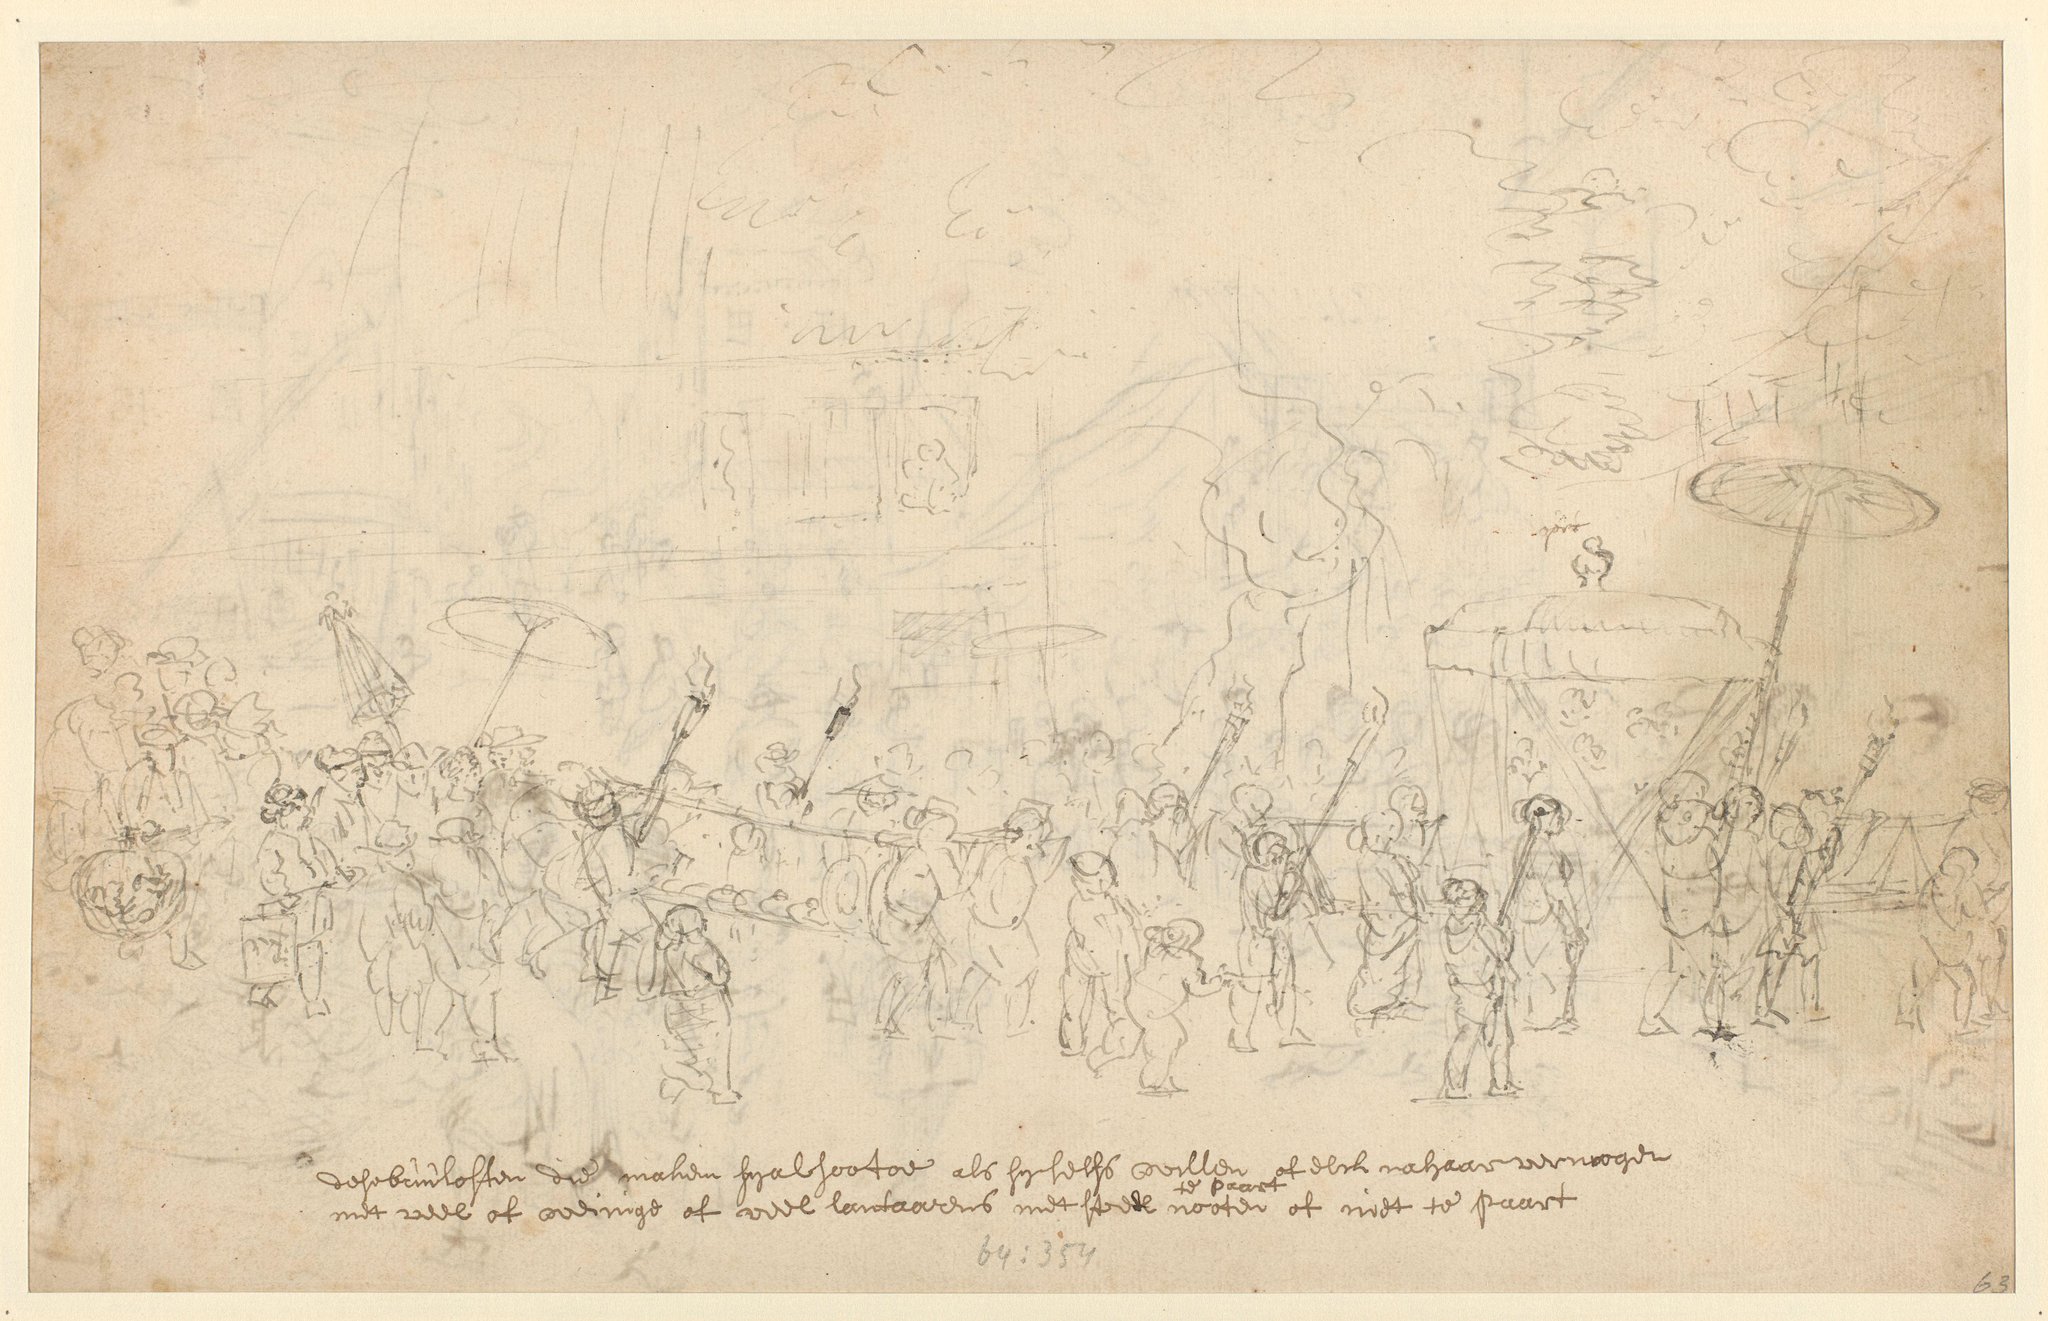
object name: drawing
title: Bruiloftsstoet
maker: wouter schouten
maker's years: 1638-1704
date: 1660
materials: ink, paper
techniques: pen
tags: indië